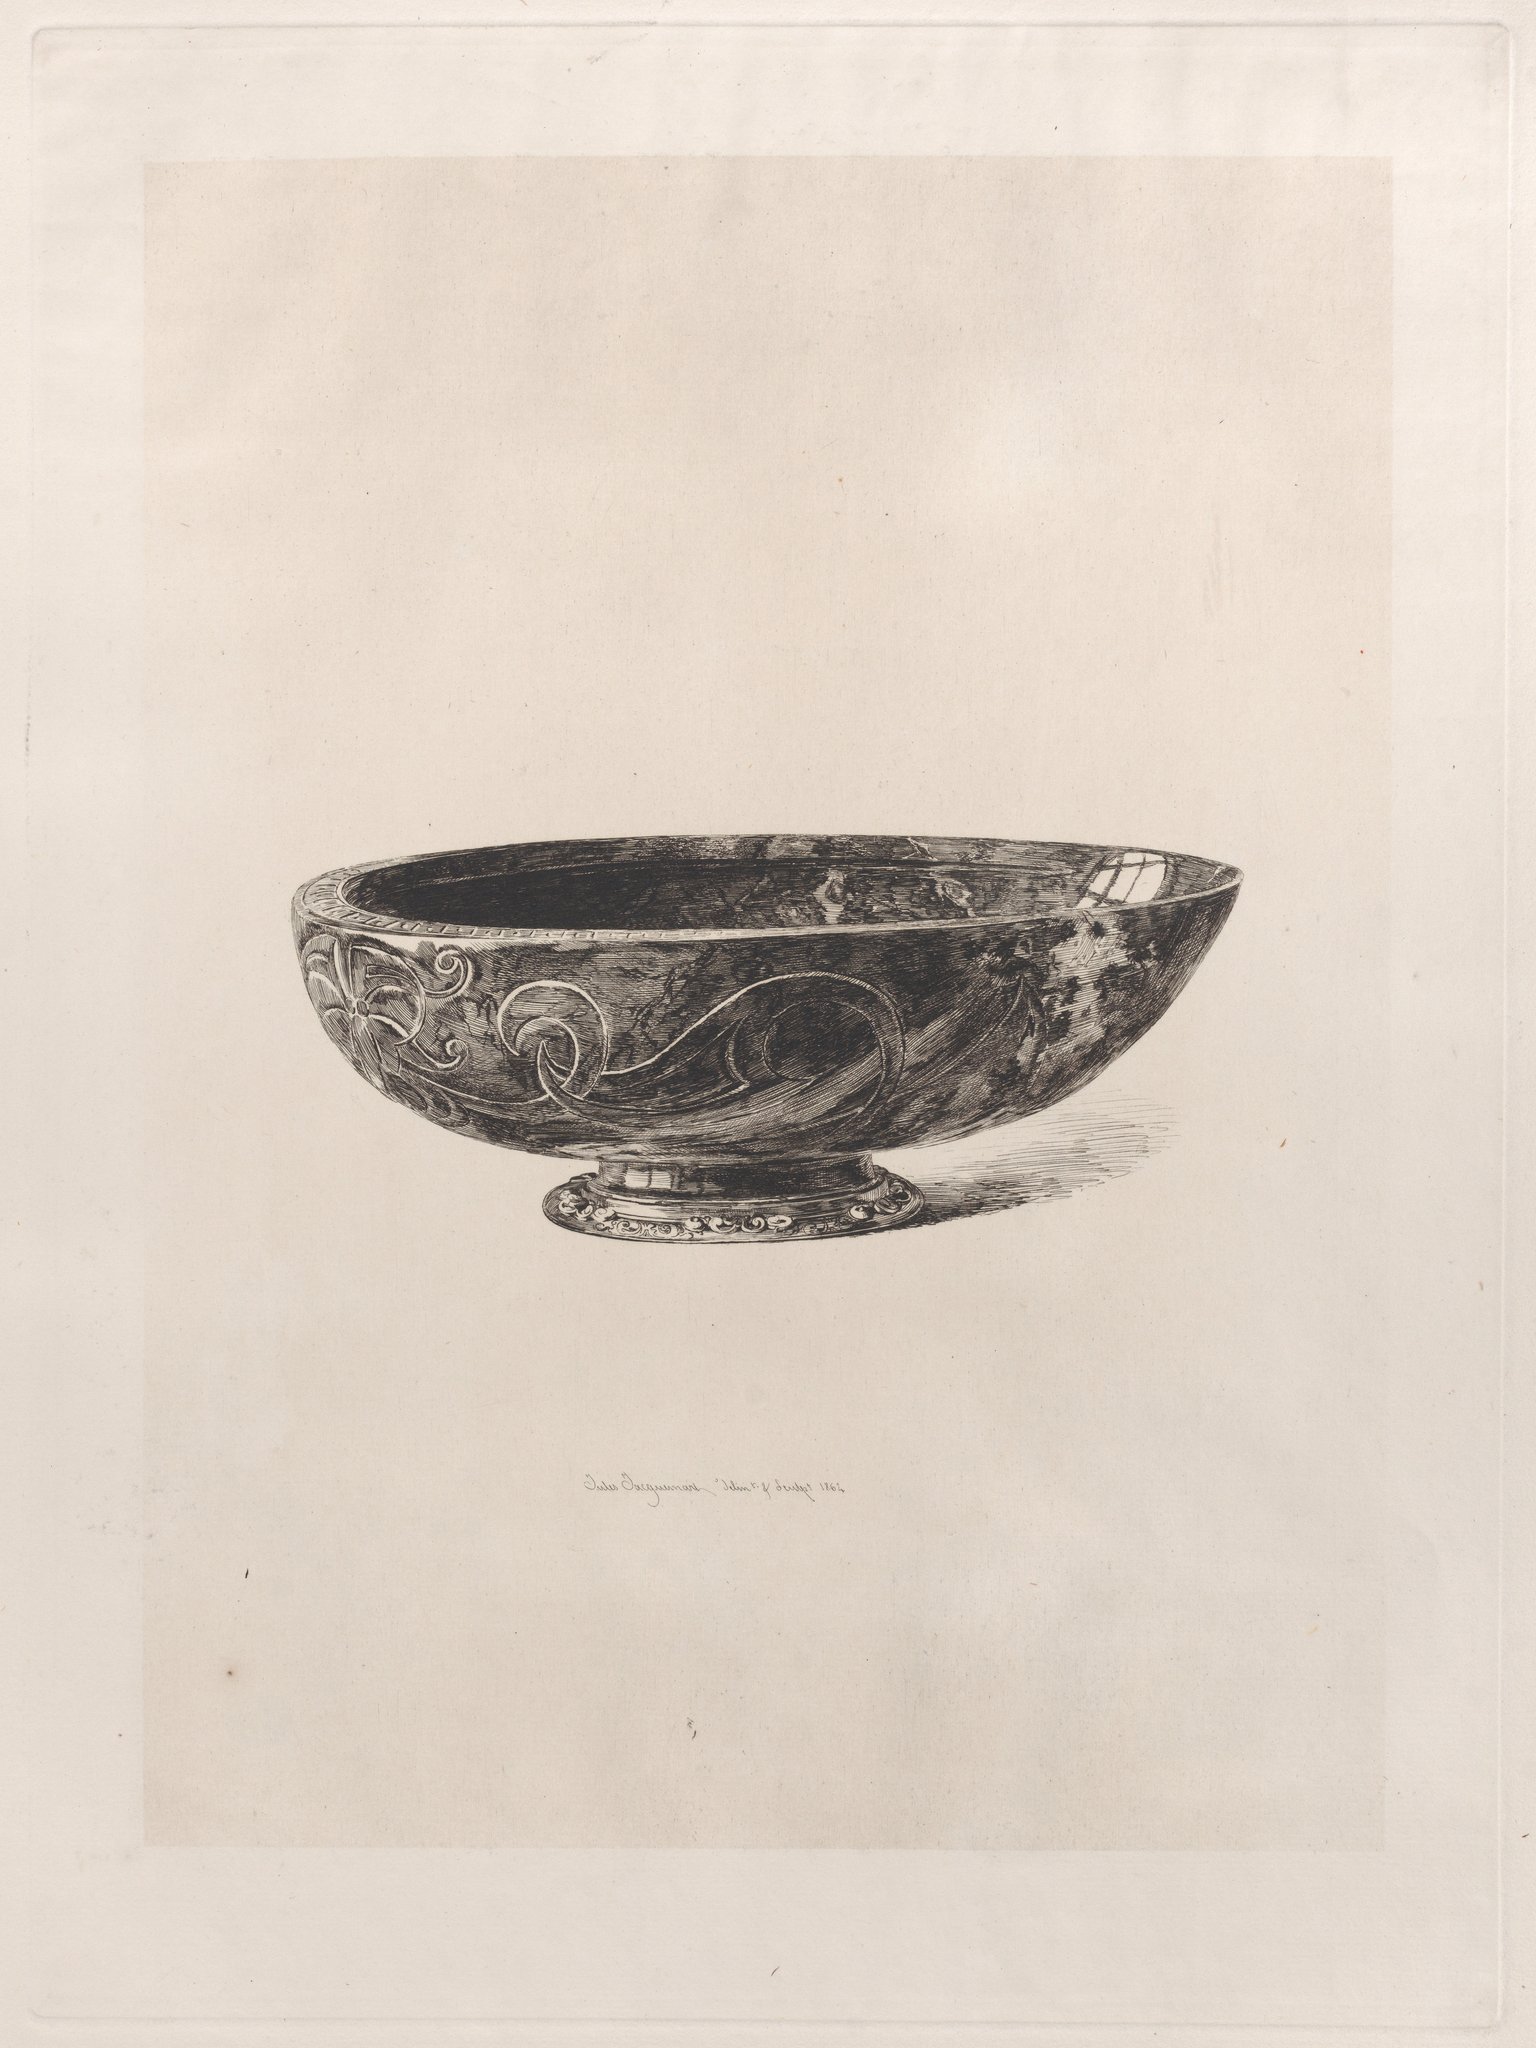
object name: print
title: Oriental Jasper Bezel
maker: jules-ferdinand jacquemart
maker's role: artist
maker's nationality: french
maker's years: 1837-1880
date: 1864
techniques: etching